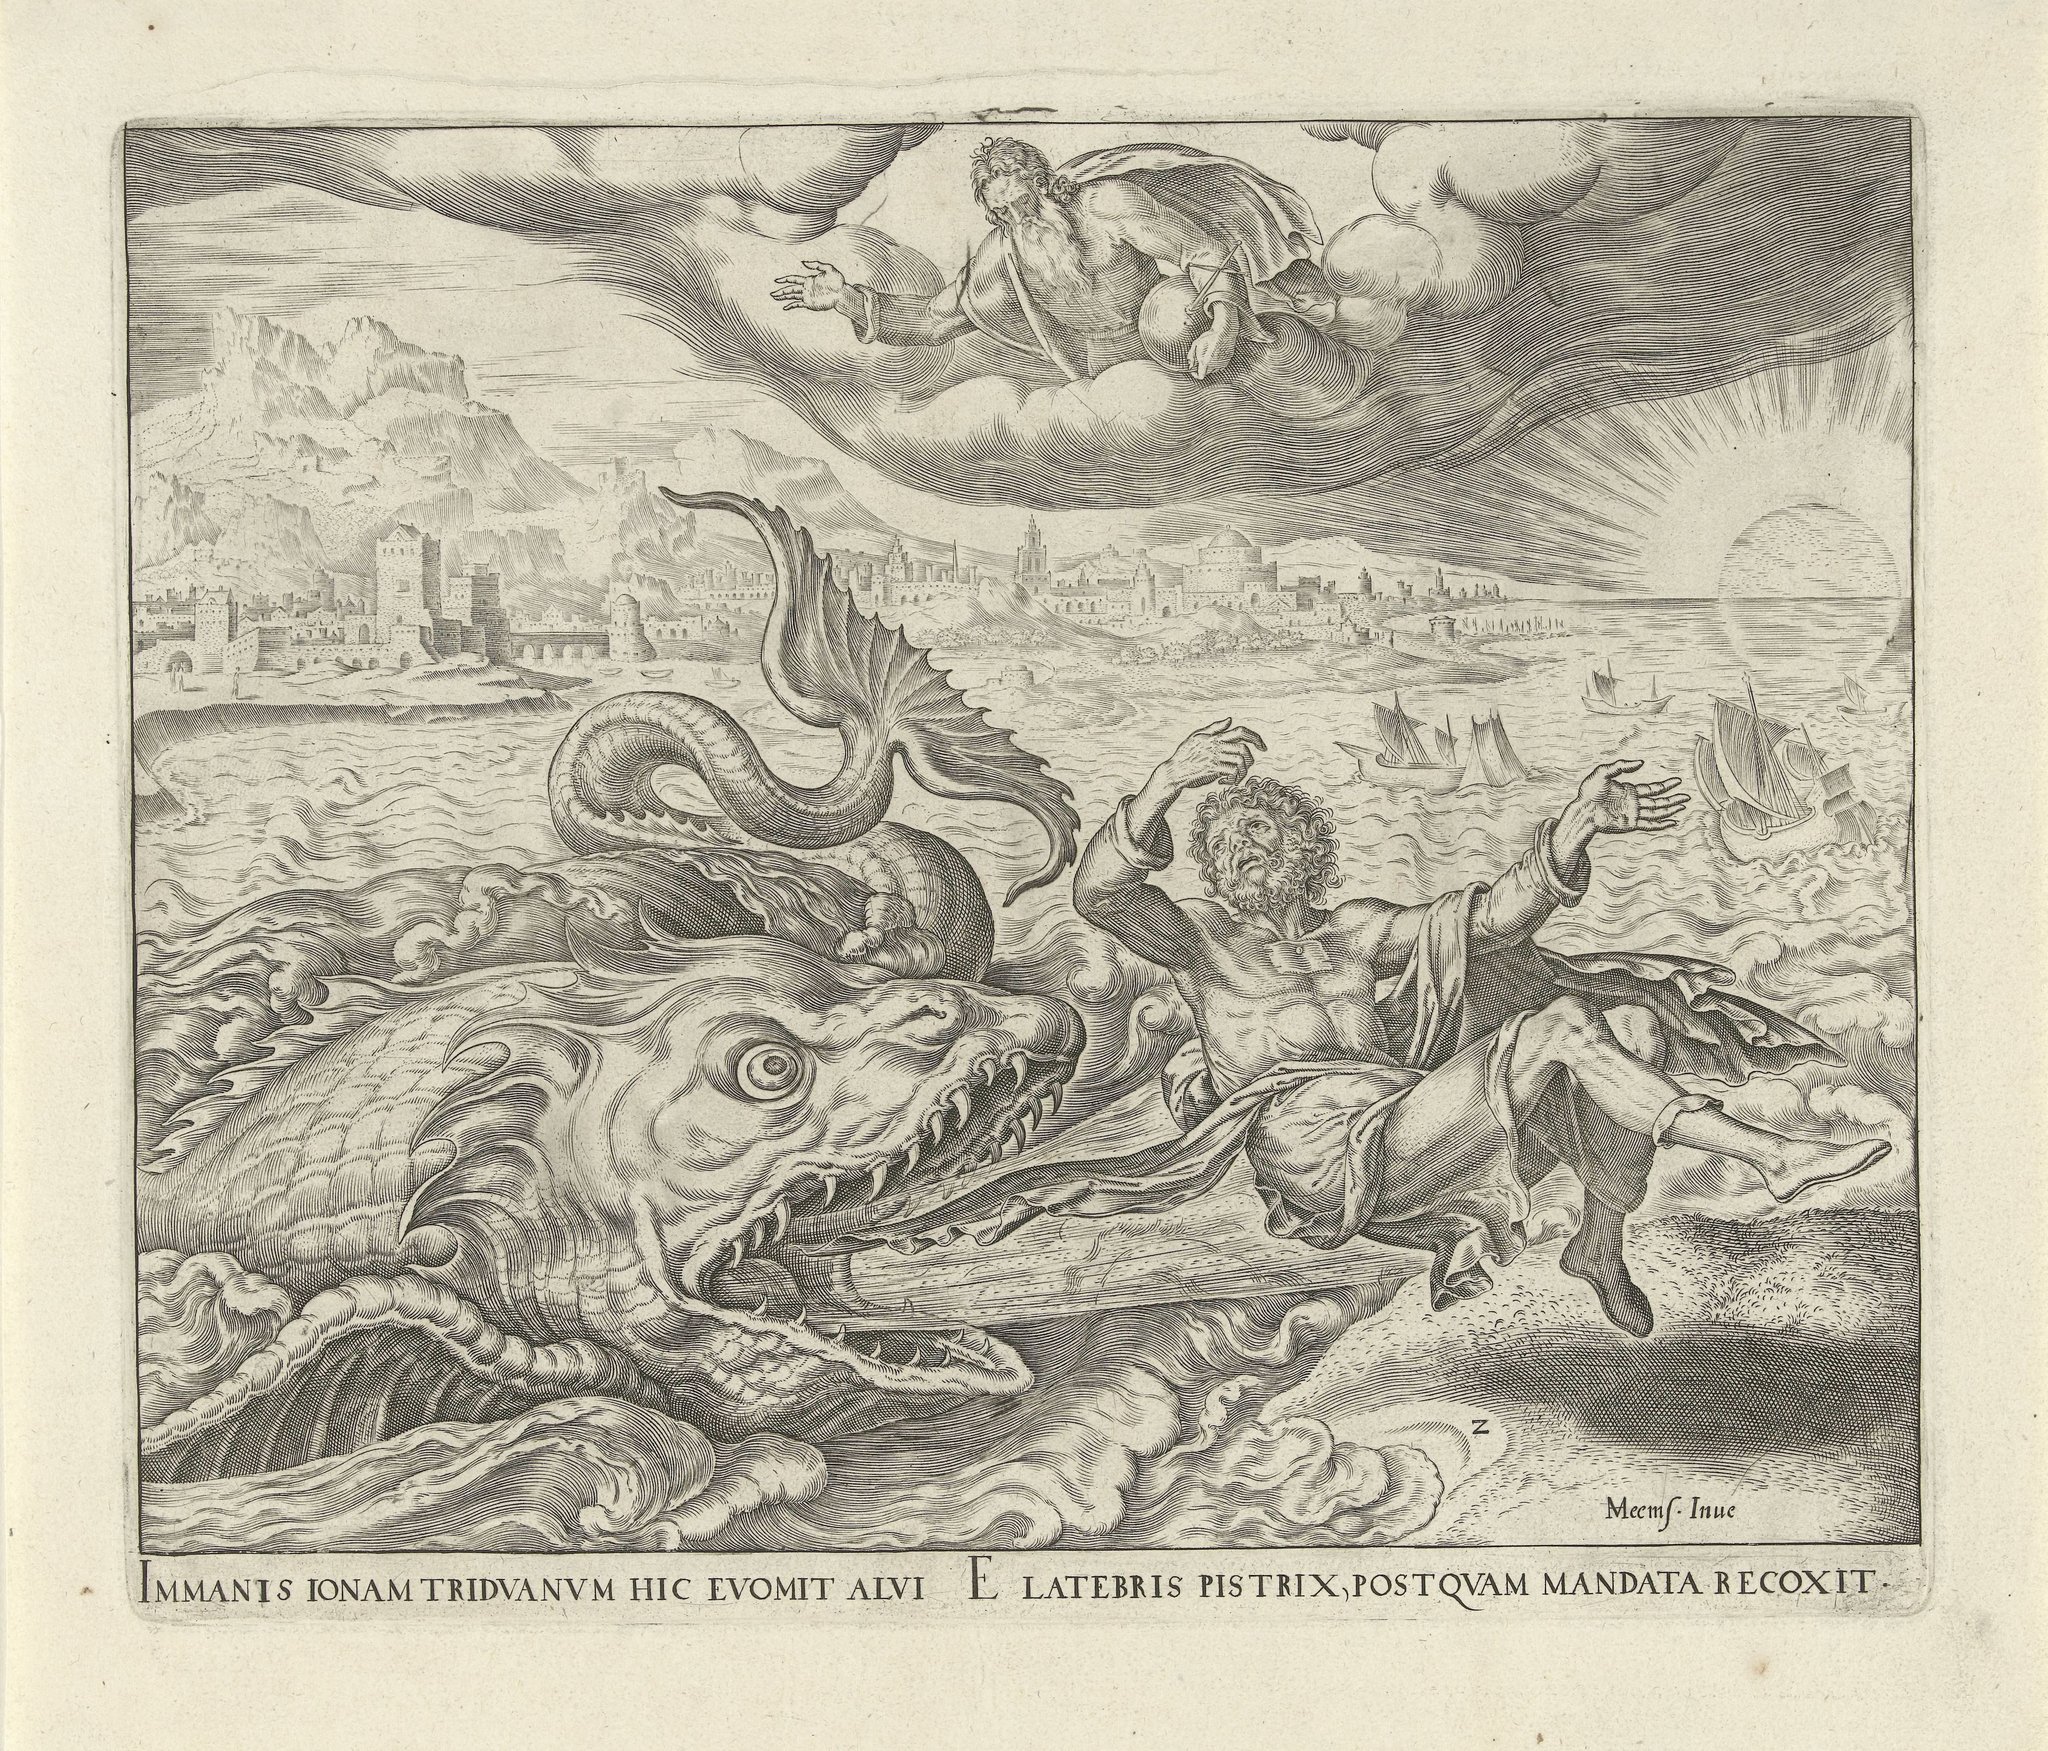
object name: print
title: De vis spuwt Jona uit op het land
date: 1596-1633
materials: paper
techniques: engraving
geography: haarlem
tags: after a three-day sojourn in the belly of the monster jonah is cast on dry land; jonah may be shown nude and bald-headed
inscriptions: collector's mark: Lugt 2228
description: Na drie dagen en nachten in de buik van de vis overleefd te hebben spuwt de vis Jona uit op het land. God kijkt naar Jona vanuit een wolk. Het water op zee is rustig en de zon gaat net op.